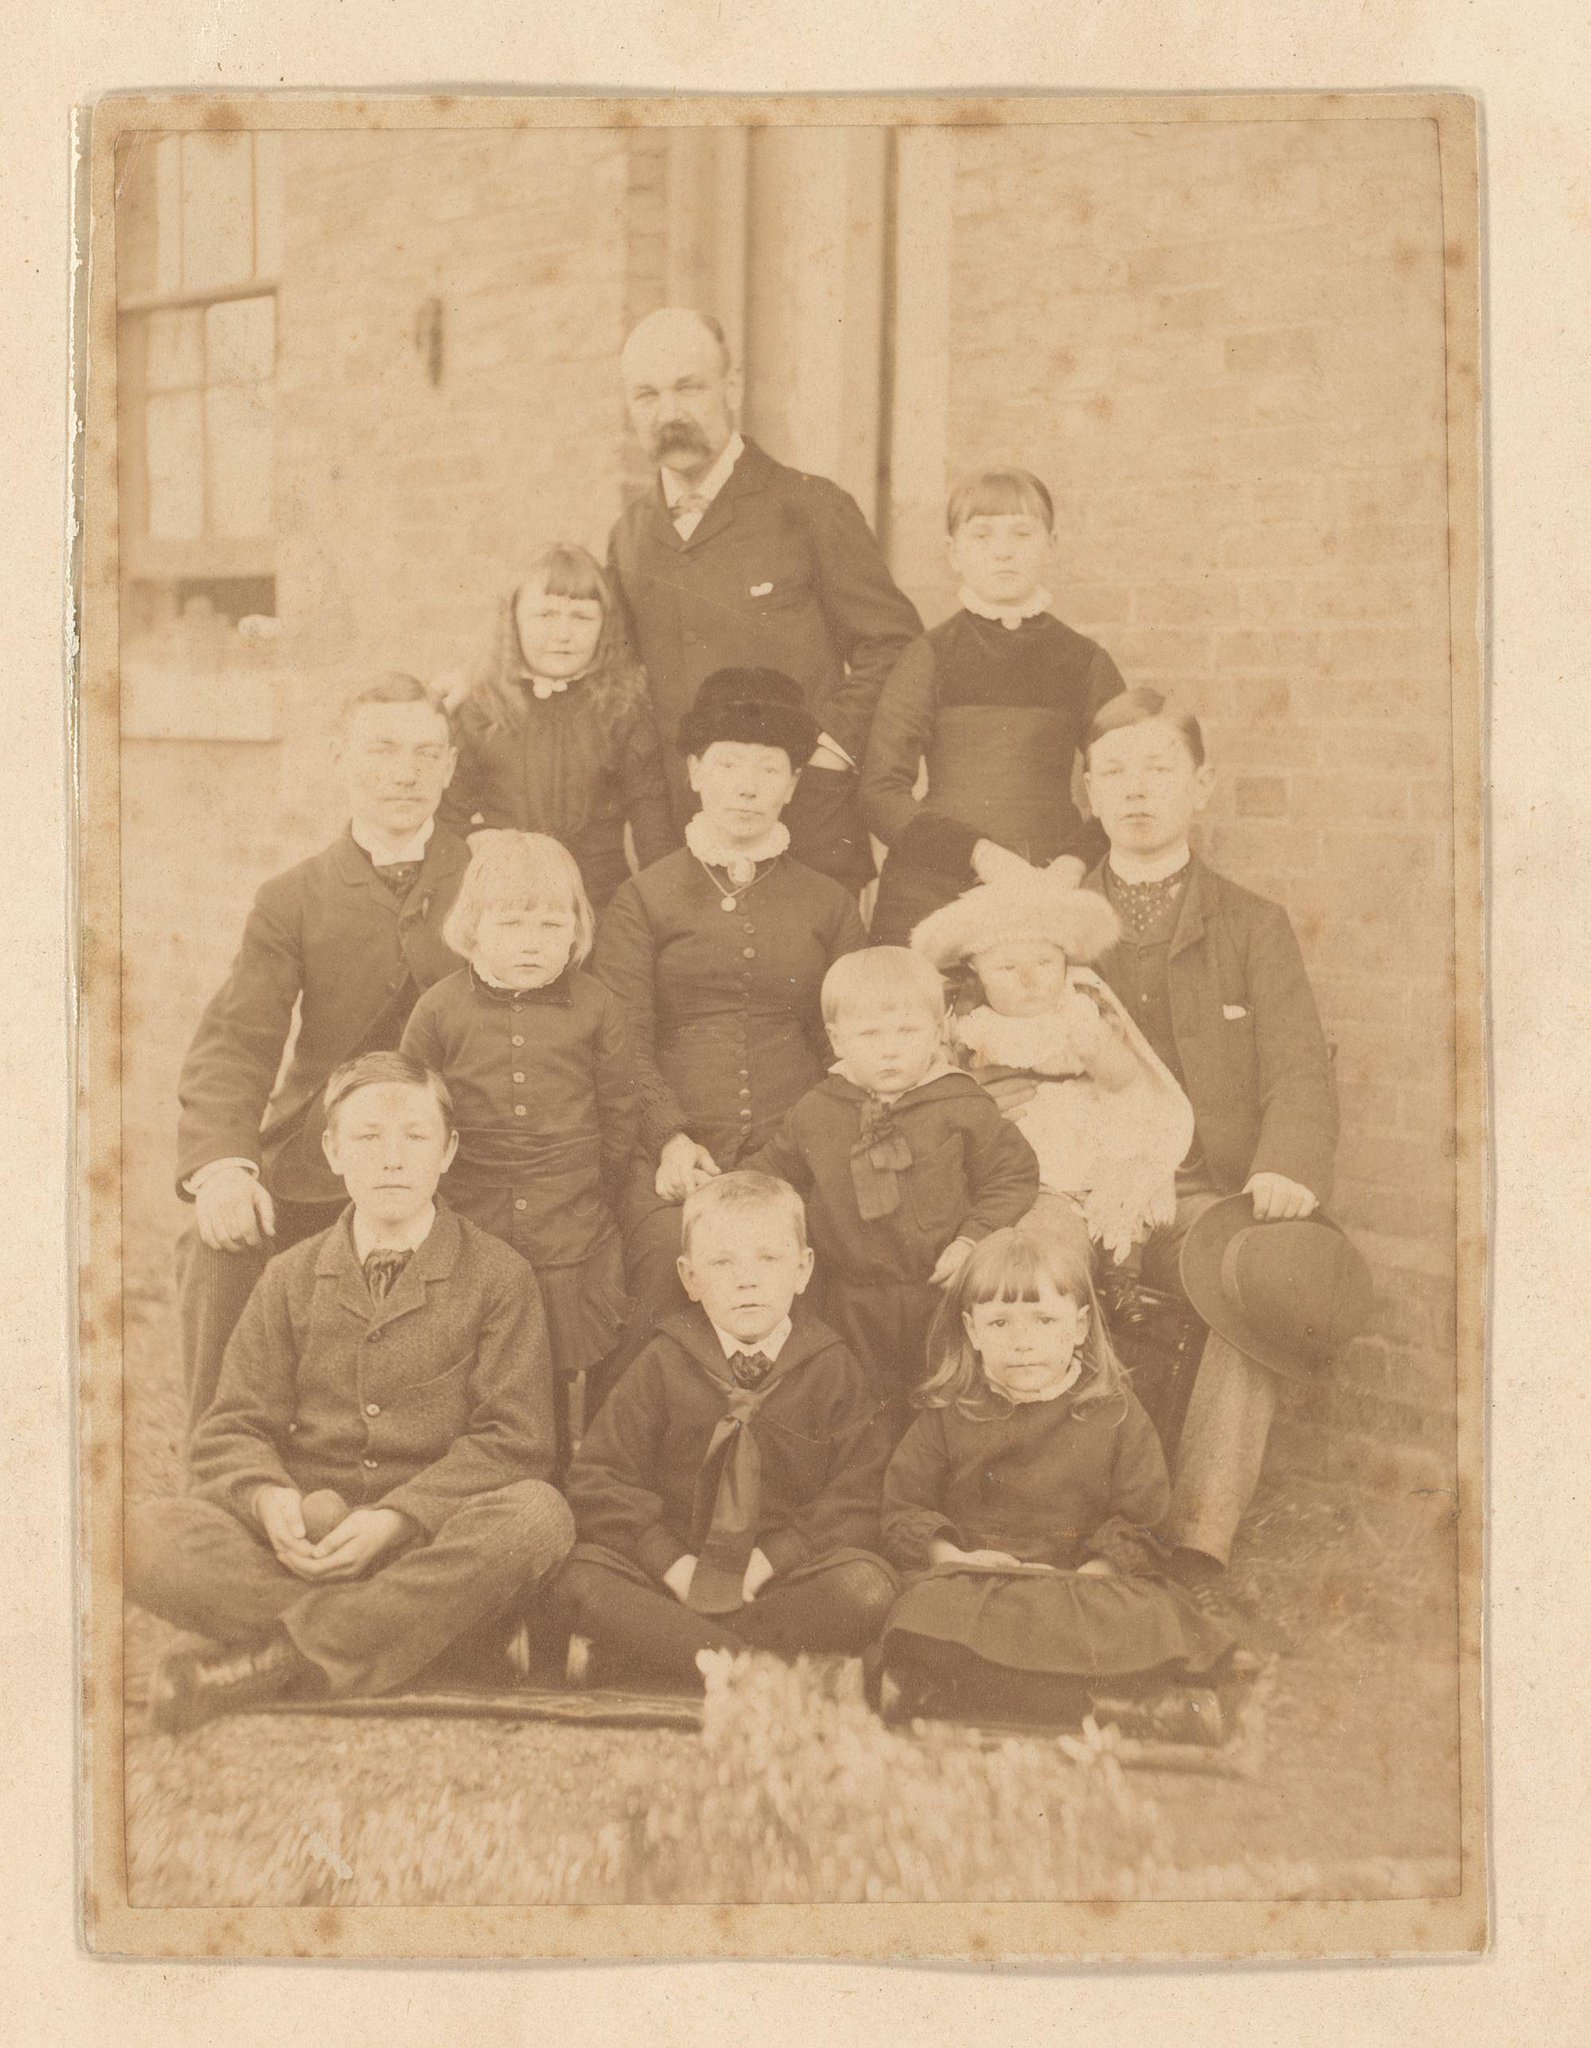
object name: photograph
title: Groepsportret van een familie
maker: Anonymous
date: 1883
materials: cardboard, paper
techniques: albumen print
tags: child(ren) with other members of the family, historical persons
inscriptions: inscription: ‘To Aunt Ann/ With love from all at Shobury [...] Monday/ 1883’